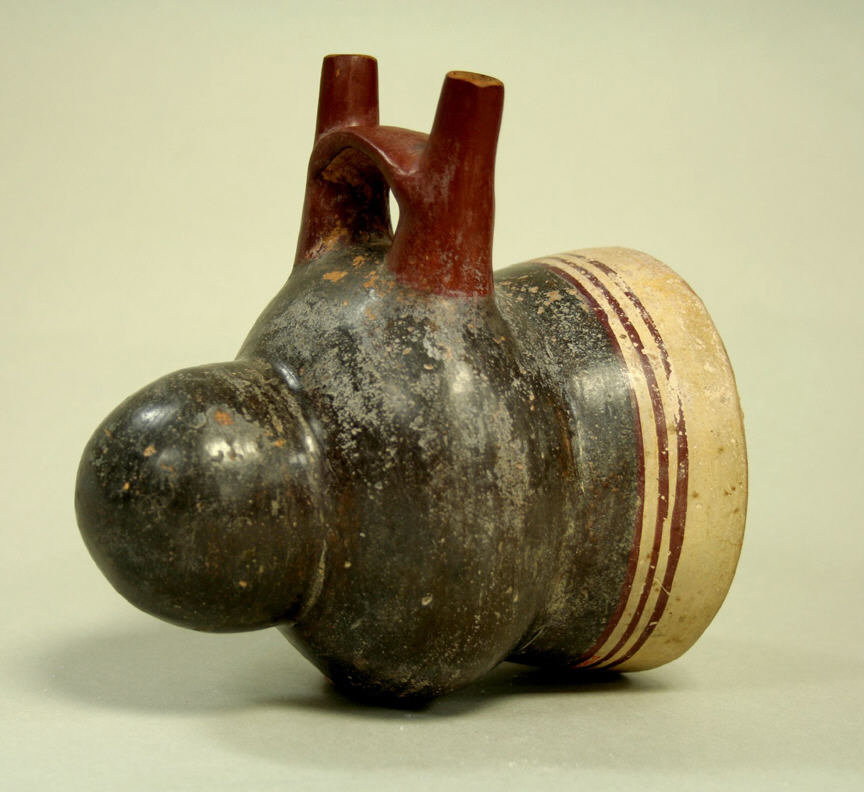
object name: bottle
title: Bottle, Drum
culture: nasca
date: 1-600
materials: ceramic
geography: peru